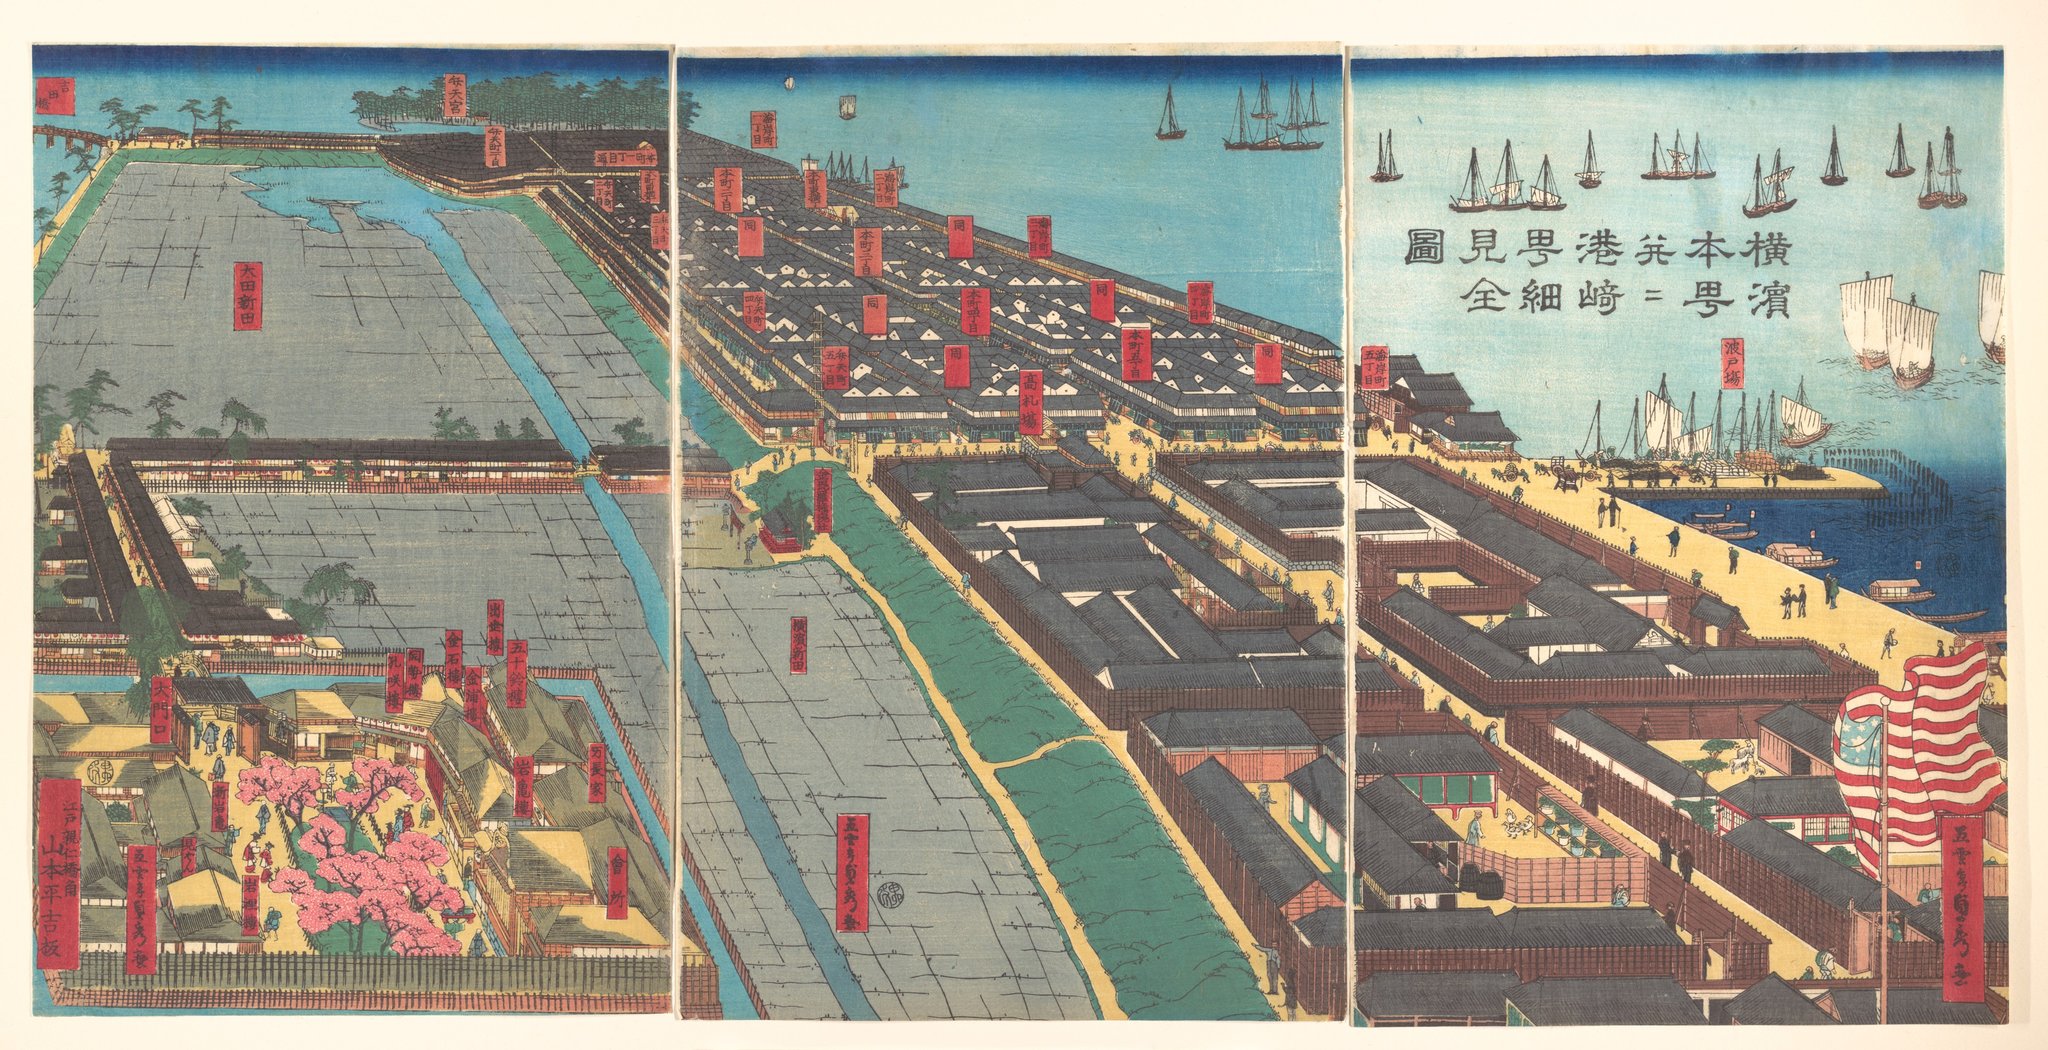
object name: print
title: Detailed Print of Yokohama Hon-chō and the Miyozaki Pleasure Quarter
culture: japanese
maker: utagawa (gountei) sadahide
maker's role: artist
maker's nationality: japanese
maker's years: 1807-1873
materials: ink, paper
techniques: woodblock print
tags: buildings,boats